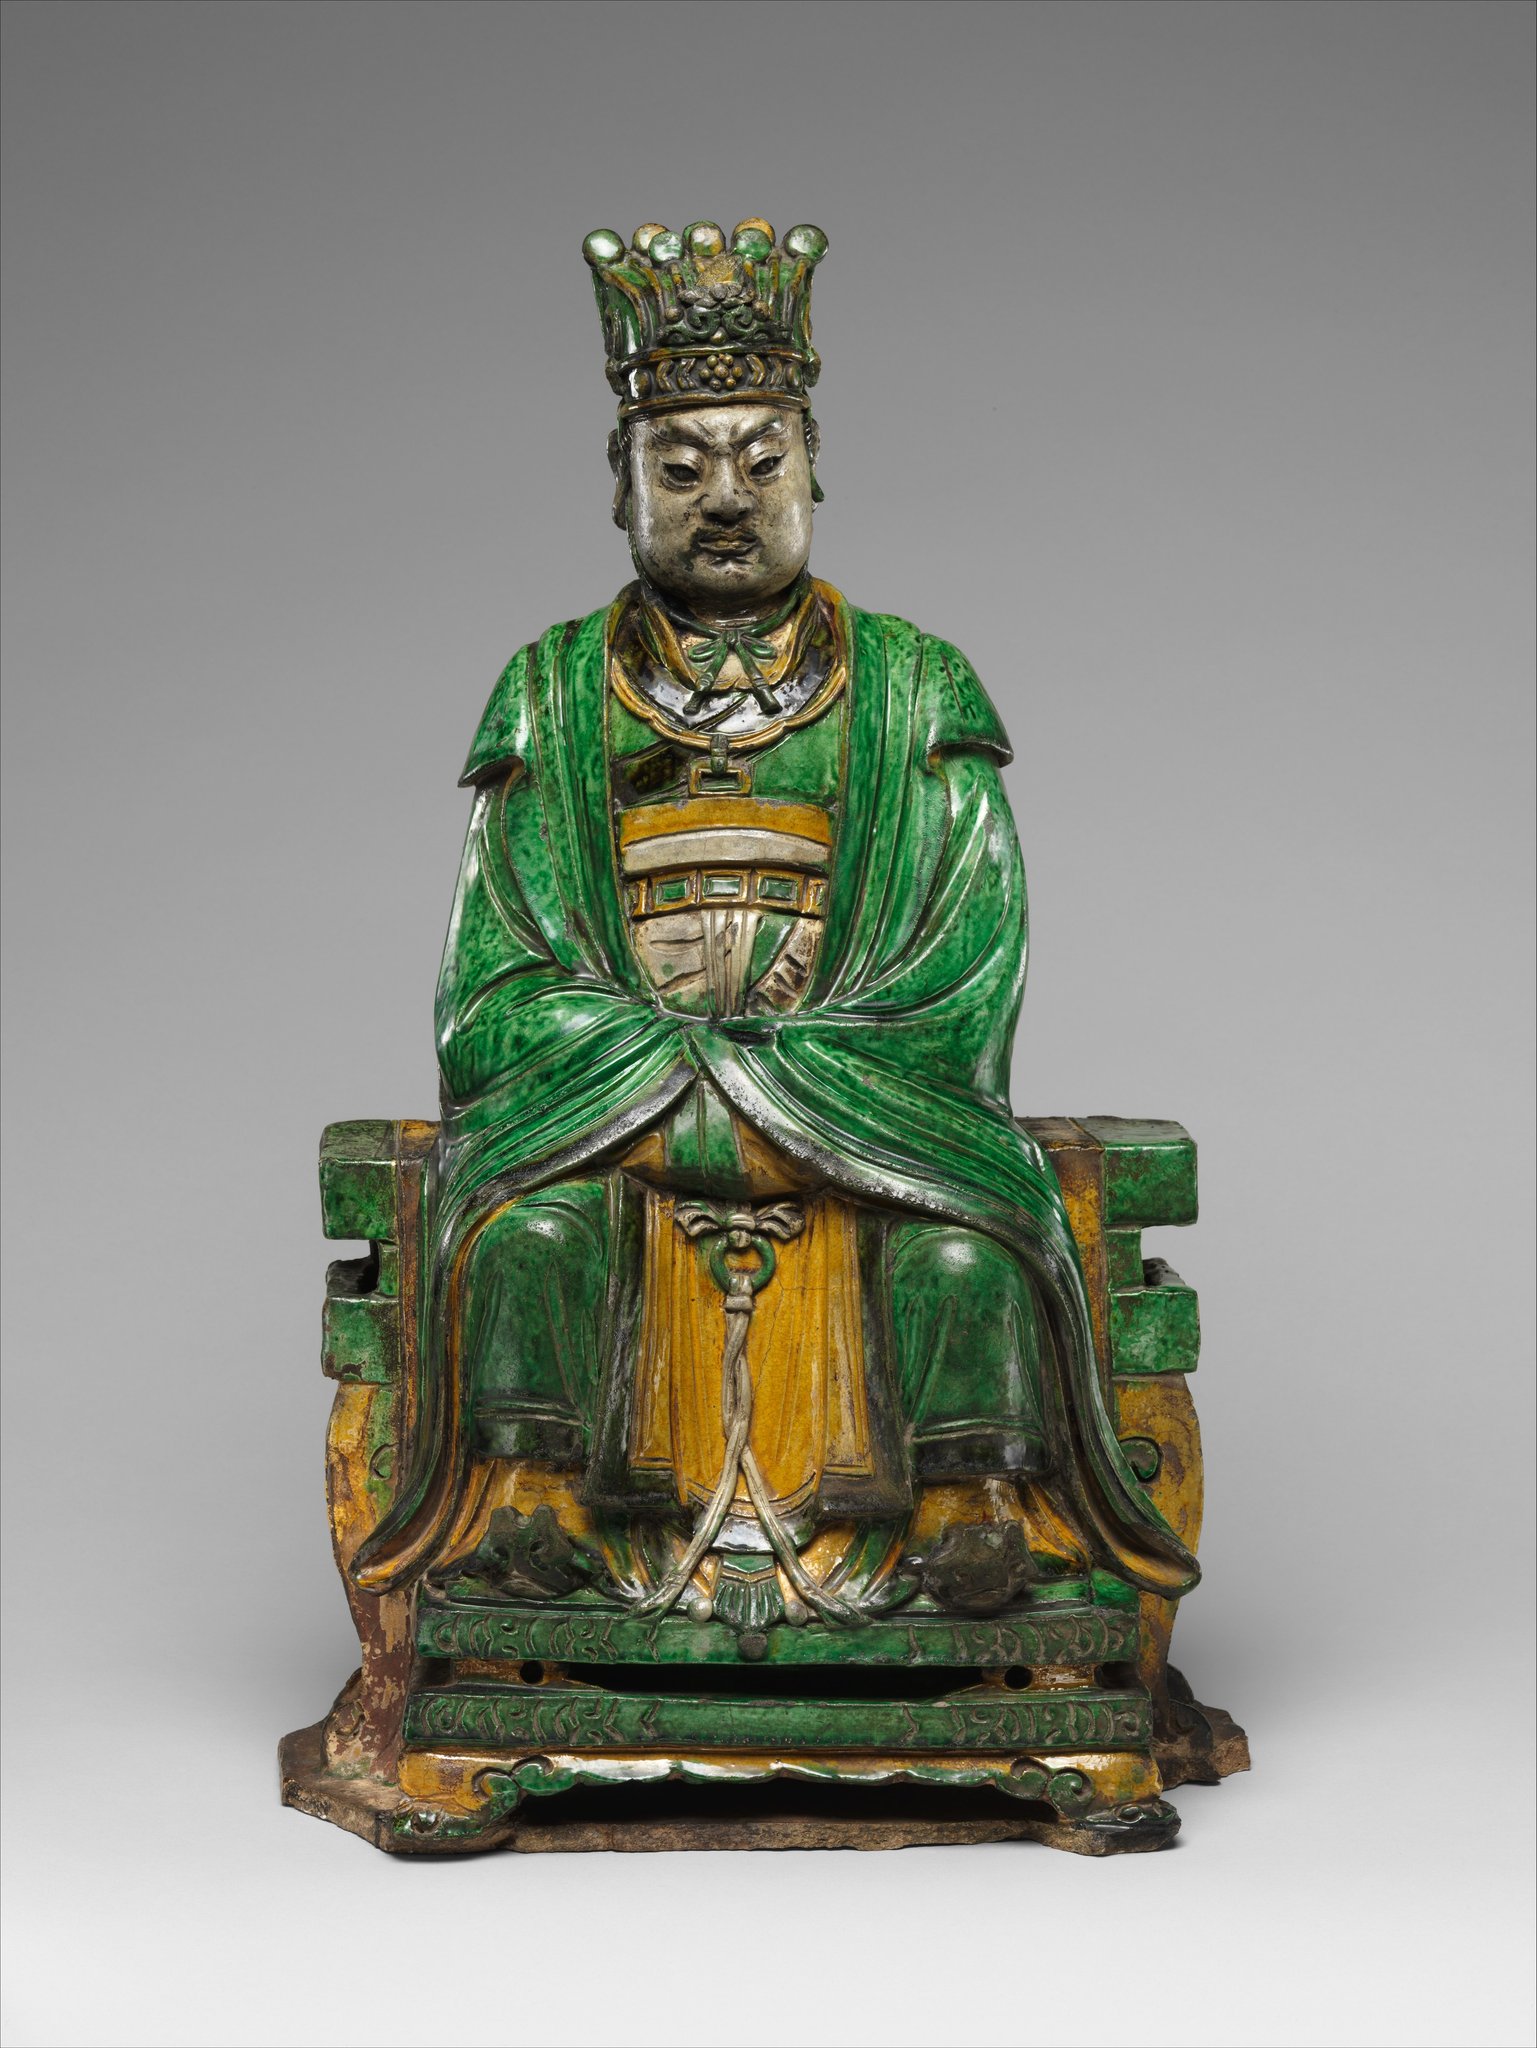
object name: figure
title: Daoist divine official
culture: chinese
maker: qiao bin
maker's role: artist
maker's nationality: chinese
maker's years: 1481-1507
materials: stoneware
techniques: glazing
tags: men,daoism